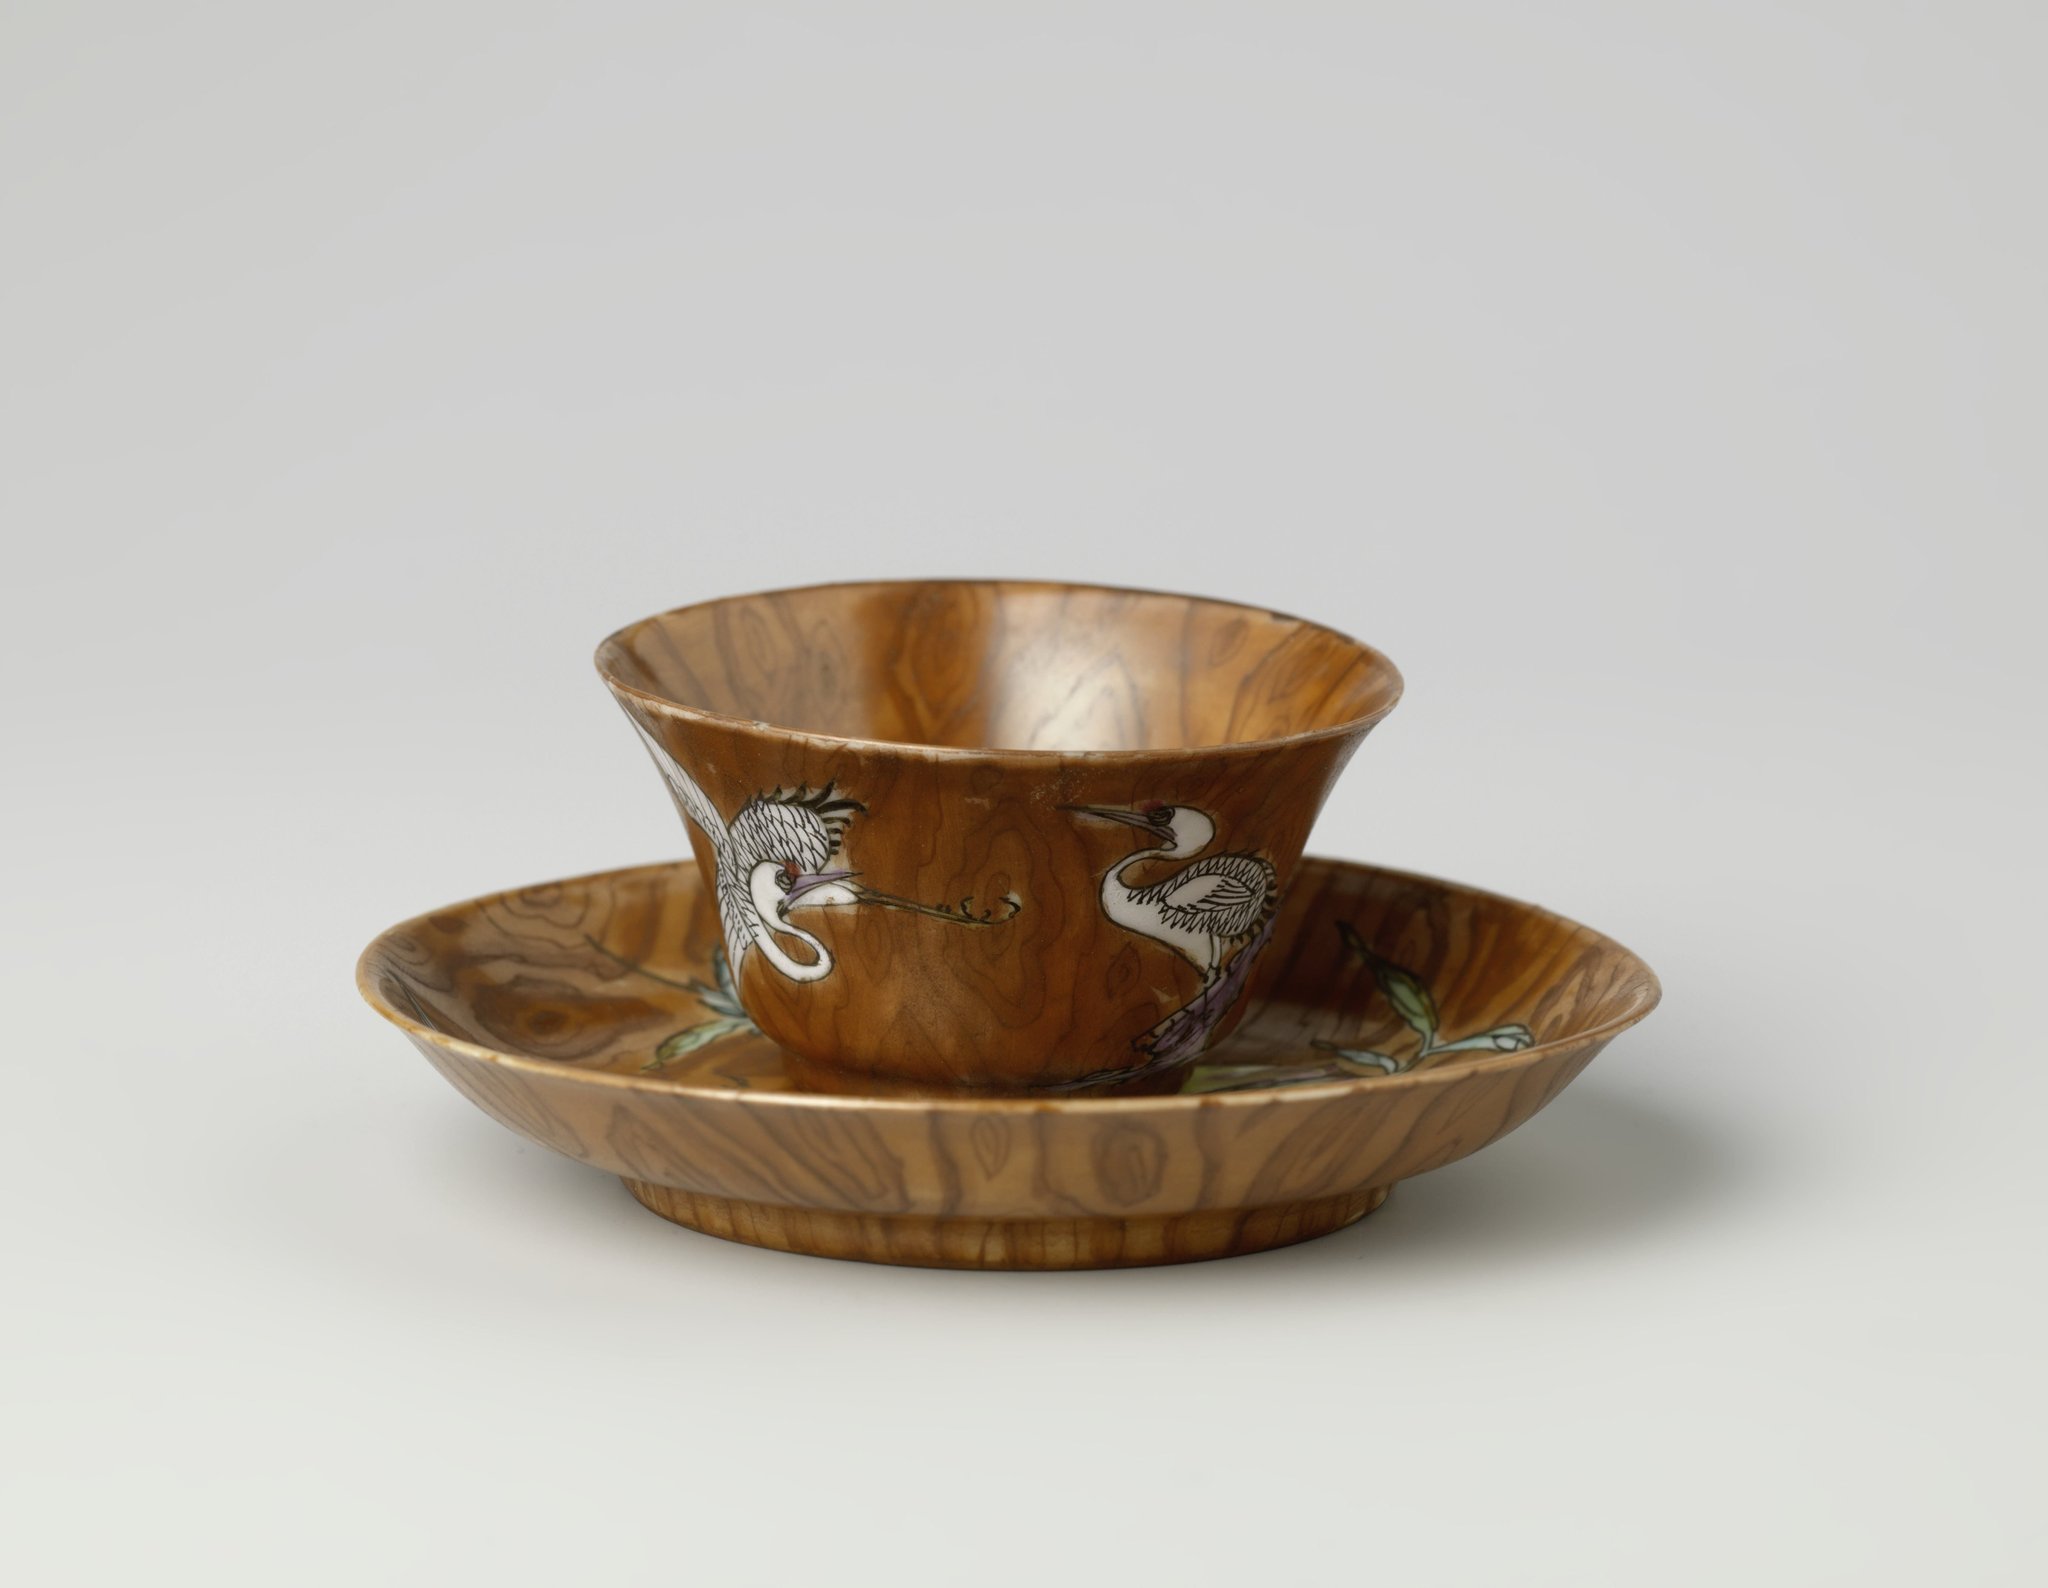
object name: kop en schotel, kop en schotel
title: Cup and saucer with peachtree and crane on a woodcolored ground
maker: Anonymous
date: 1730-1750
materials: glaze, paint, porcelain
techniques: firing, turning, vitrification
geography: china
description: Kop en schotel van porselein met spreidende wand, bedekt met een roodbruin glazuur en beschilderd op het glazuur in rood, roze, groen, geel, aubergine en zwart. De kop en schotel zijn volledig bedekt met een bruine houtimitatie; hierin uitgespaard een perzikboom (prunus) met bloemen en vruchten waarnaast twee kraanvogels. Kop met dezelfde decoratie met op de bodem een perzik. Famille rose.